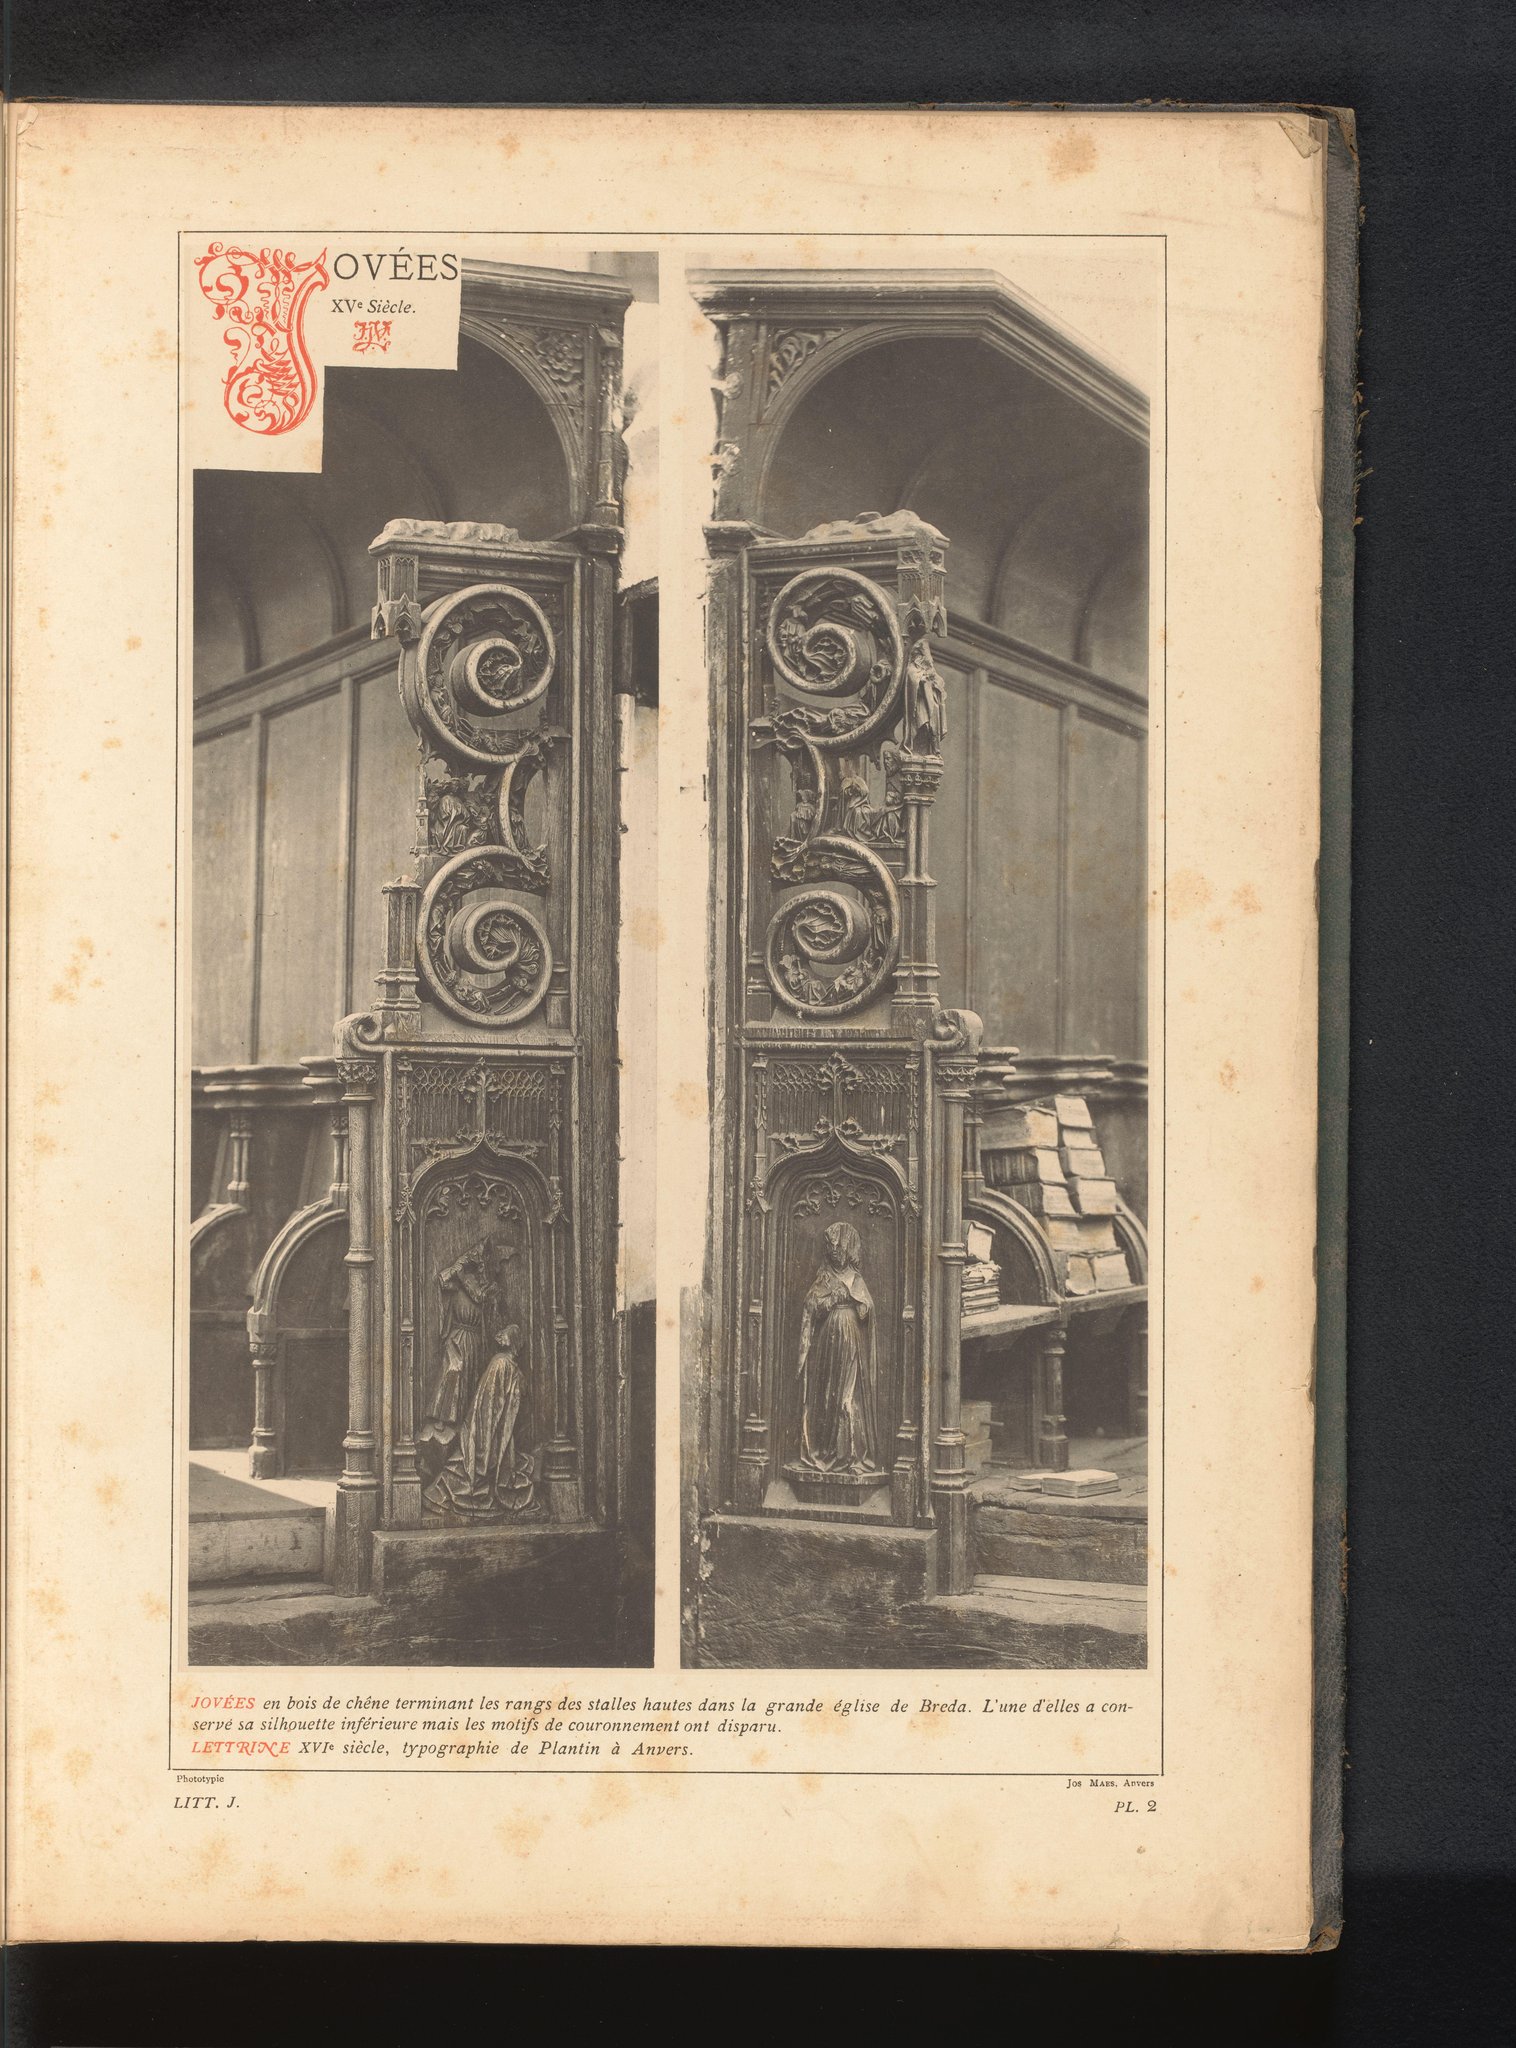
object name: photomechanical print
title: Gedecoreerde eikenhouten zijkanten van een koorbank in de Grote Kerk in Breda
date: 1875-1880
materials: paper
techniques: photograph, photolithography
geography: antwerp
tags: seats of the clergy, choir-stalls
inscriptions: monogram: ‘JJvY’, inscription: ‘LITT. J. - PL. 2.’, inscription: ‘Jovées en bois (...)’